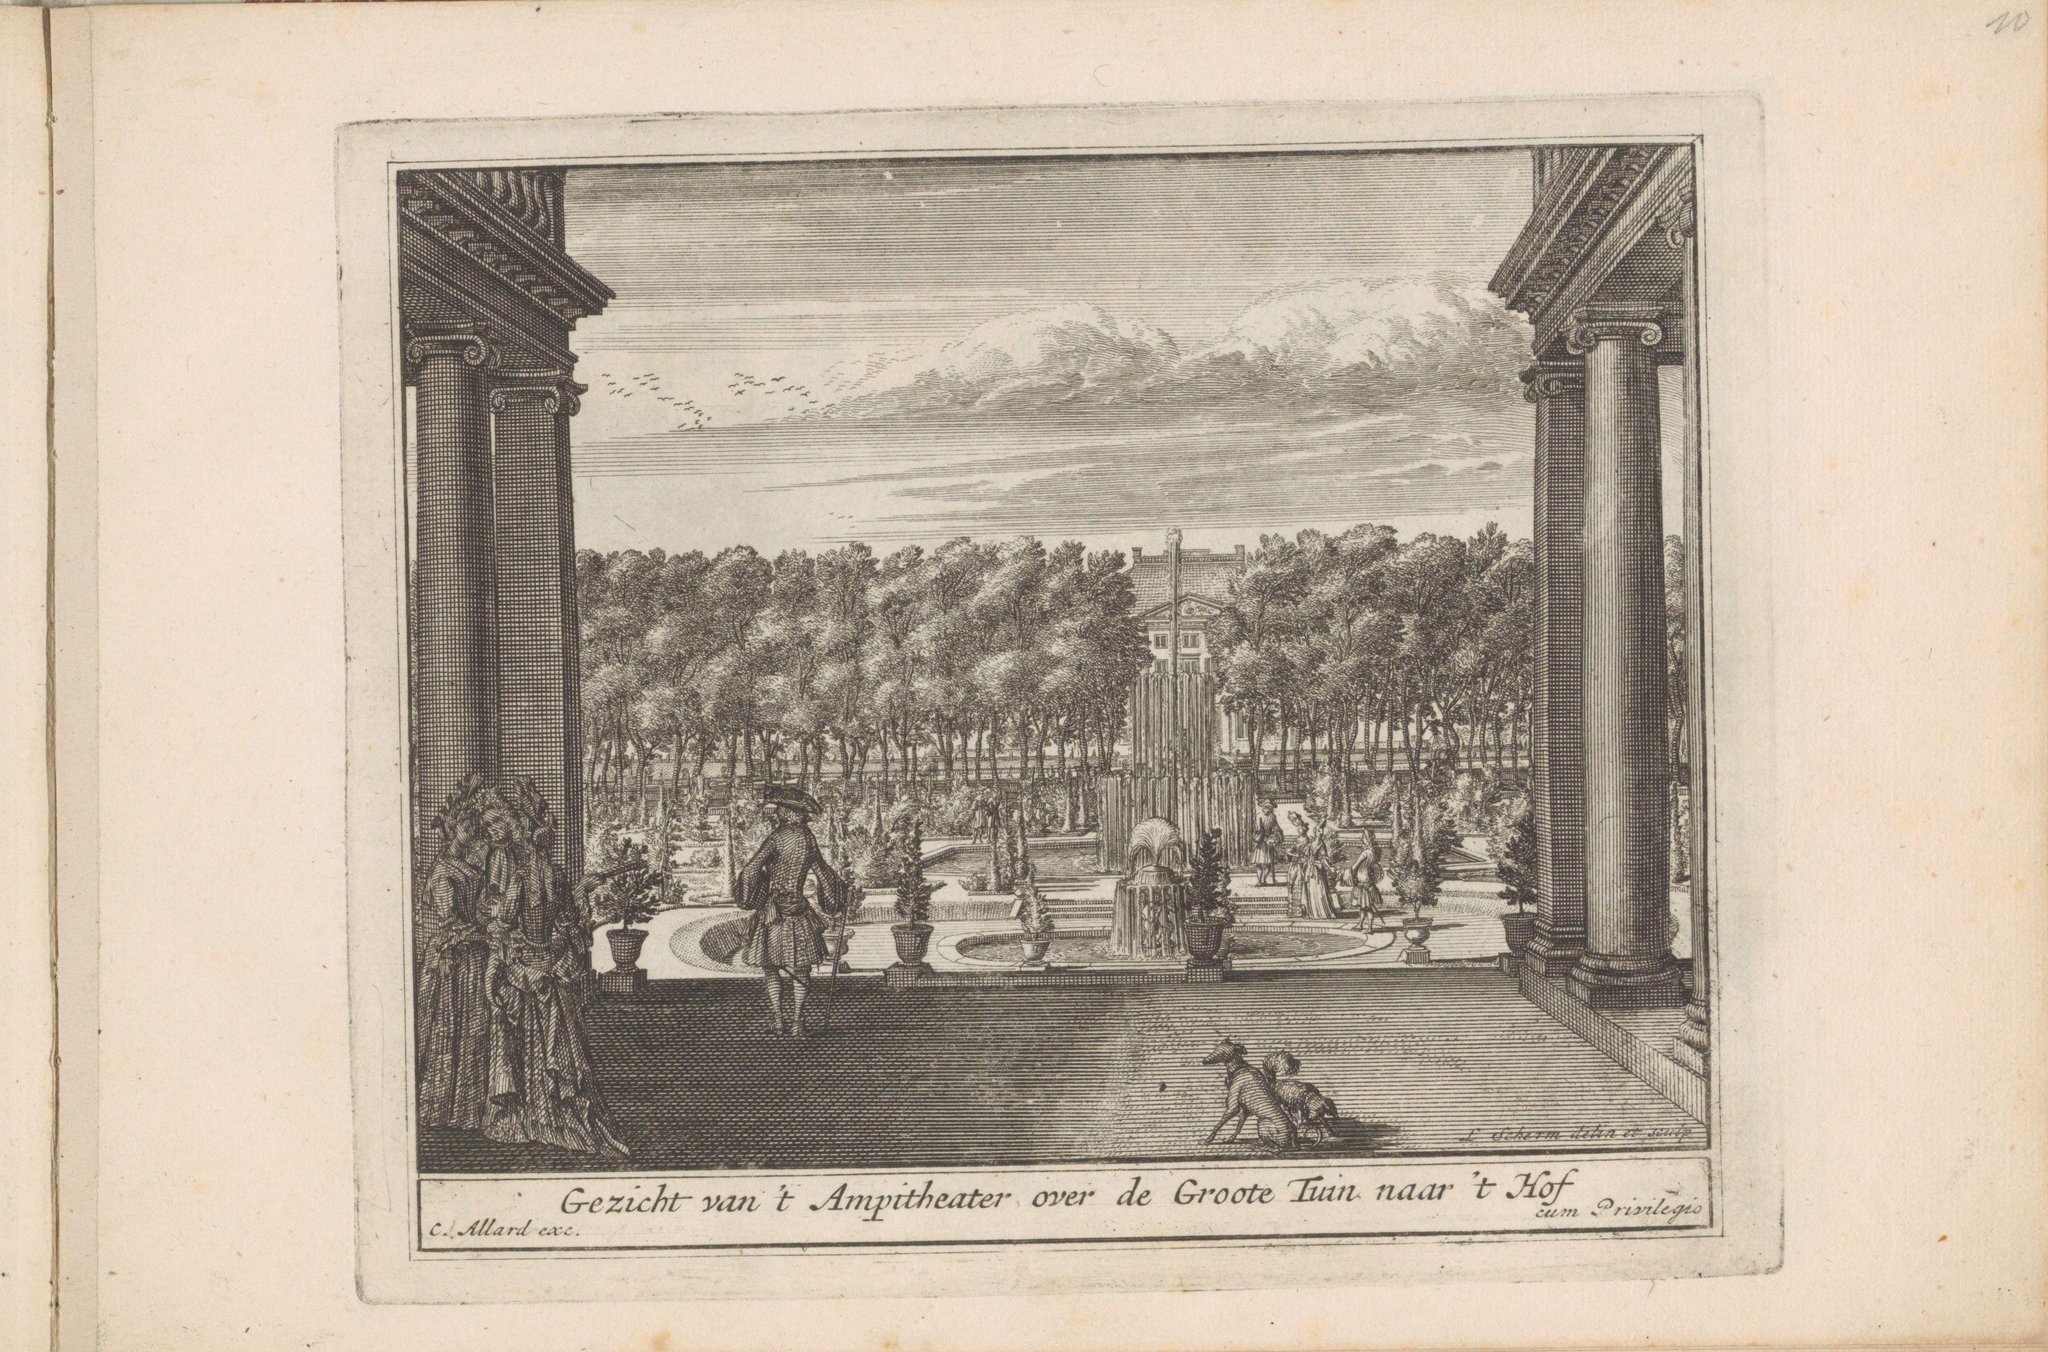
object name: print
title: Gezicht van 't Ampitheater over de Groote Tuin naar 't Hof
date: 1689-1701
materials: paper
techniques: etching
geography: amsterdam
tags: french or architectonic garden; formal garden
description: Gezicht vanaf het amfitheater over de tuin naar Paleis Het Loo. Prent maakt deel uit van een album.